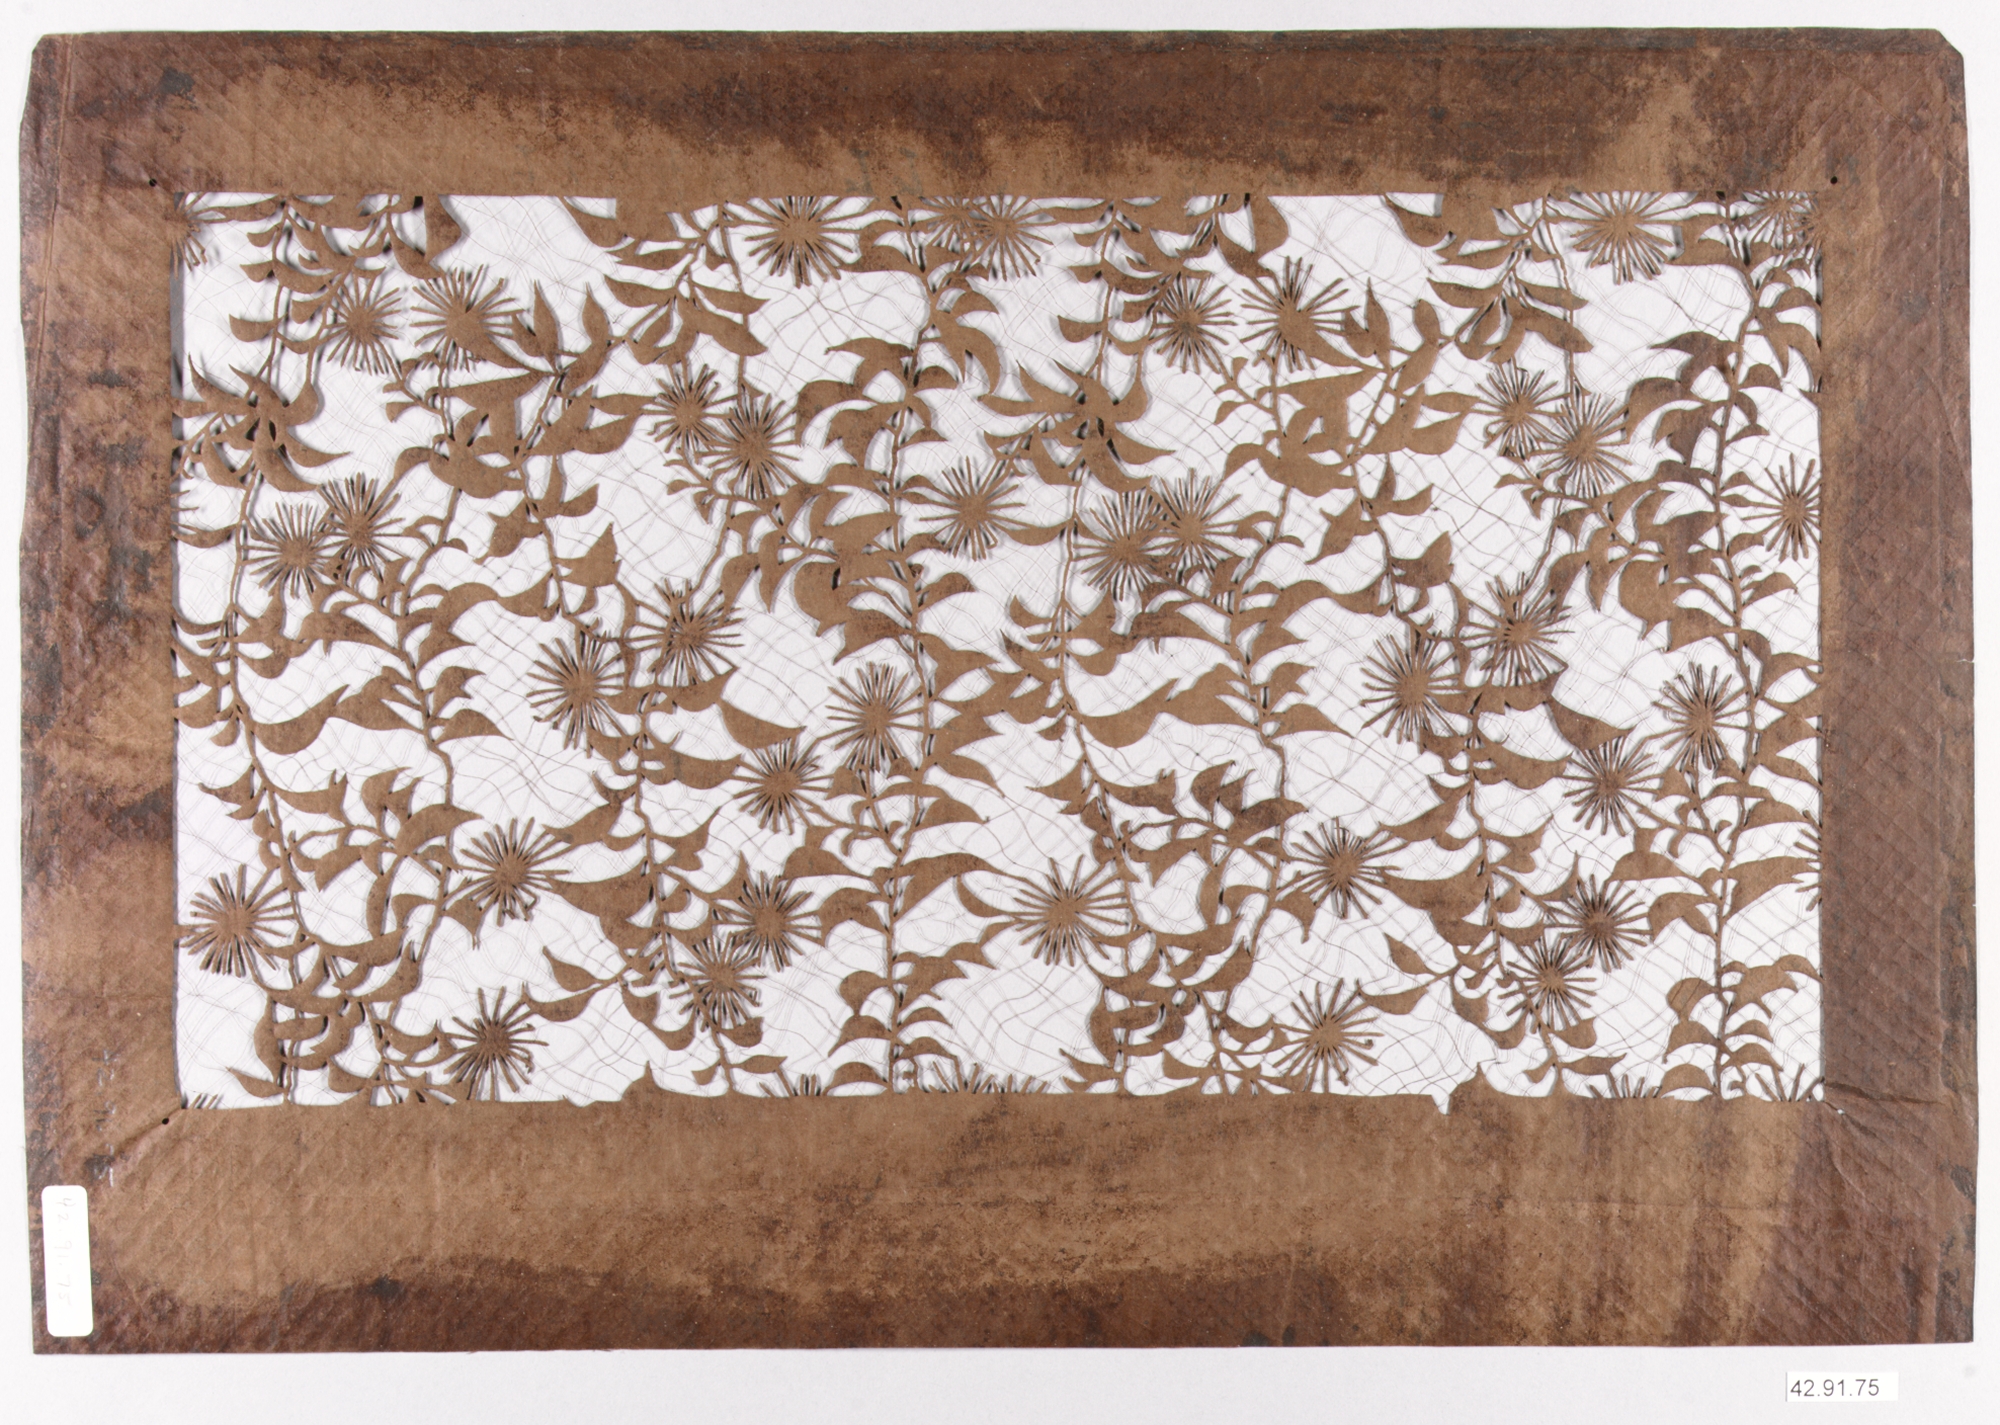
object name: stencil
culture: japanese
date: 1801-1900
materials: paper, silk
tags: plants